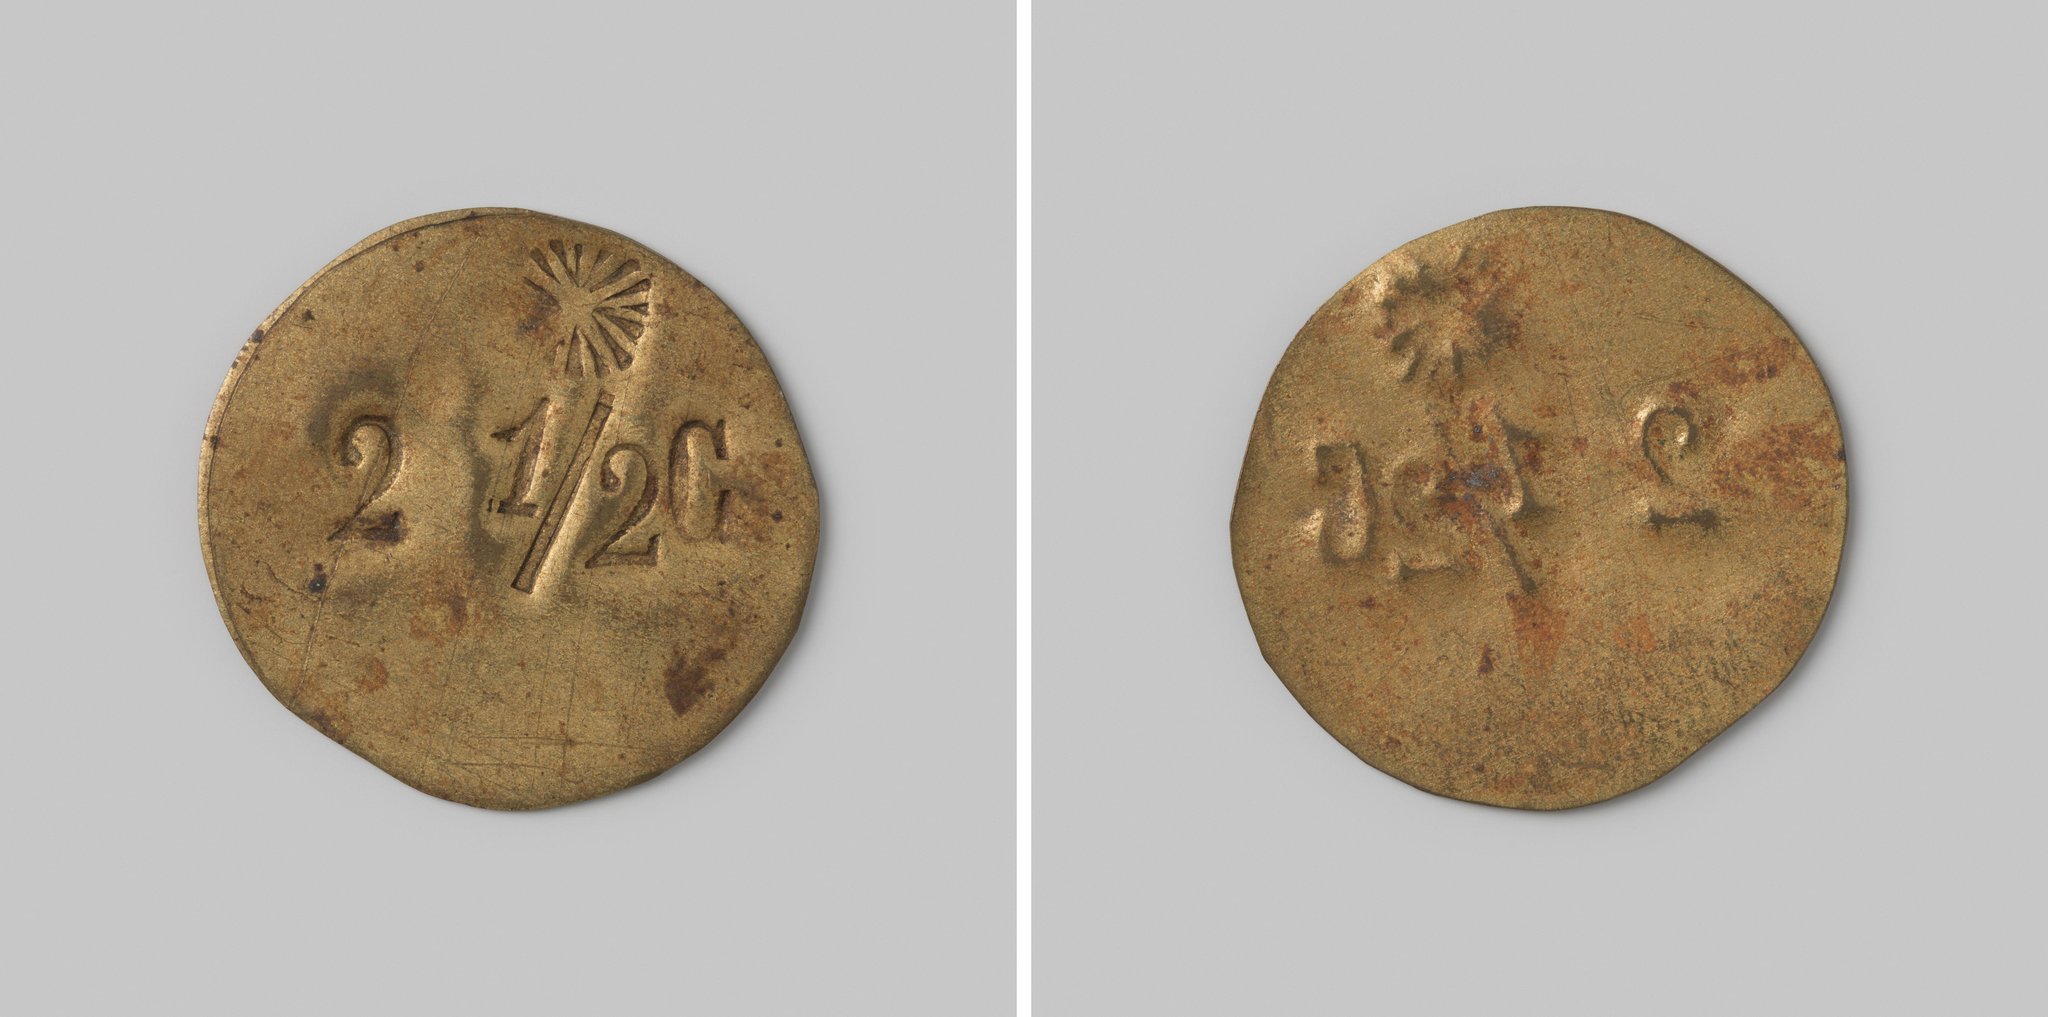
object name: history medal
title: Betaalpenning van 2½ cent van de Coöperatieve Winkelvereeniging Eendracht Maakt Magt te Hilversum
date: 1875-1900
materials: brass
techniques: printing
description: Rond messing plaatje met inwaartse instempelingen (ster) / 2½ C